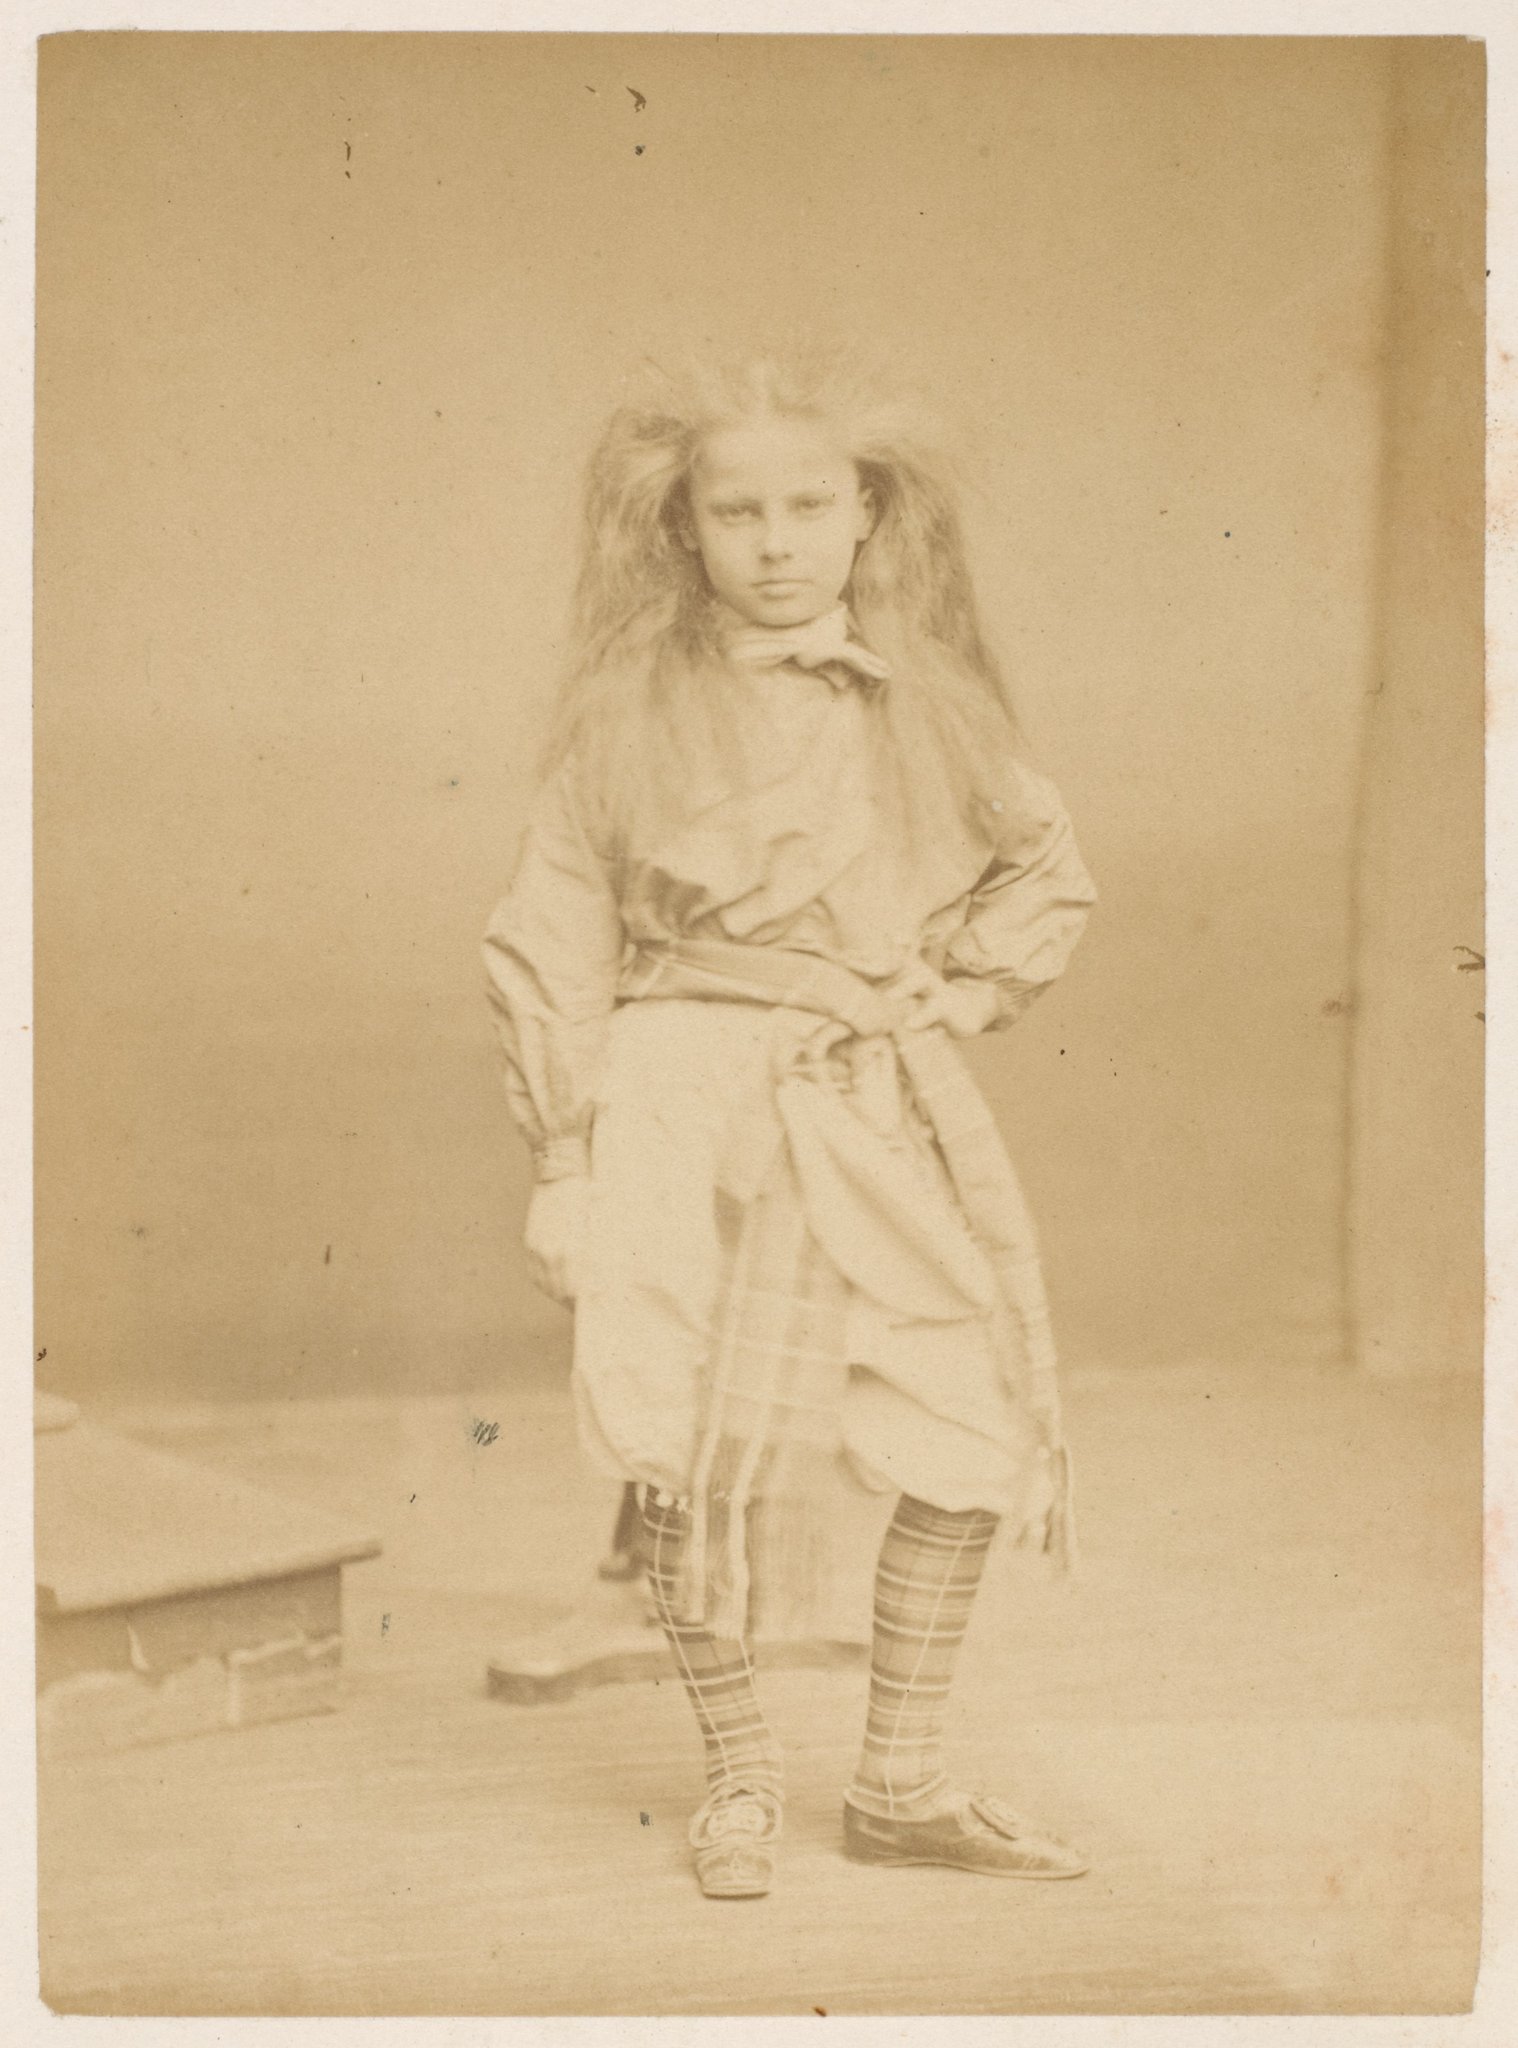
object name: photograph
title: L'Echevelé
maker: pierre-louis pierson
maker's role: artist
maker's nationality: french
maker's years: 1822-1913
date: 1860-1869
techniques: albumen silver print, glass negative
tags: girls,portraits